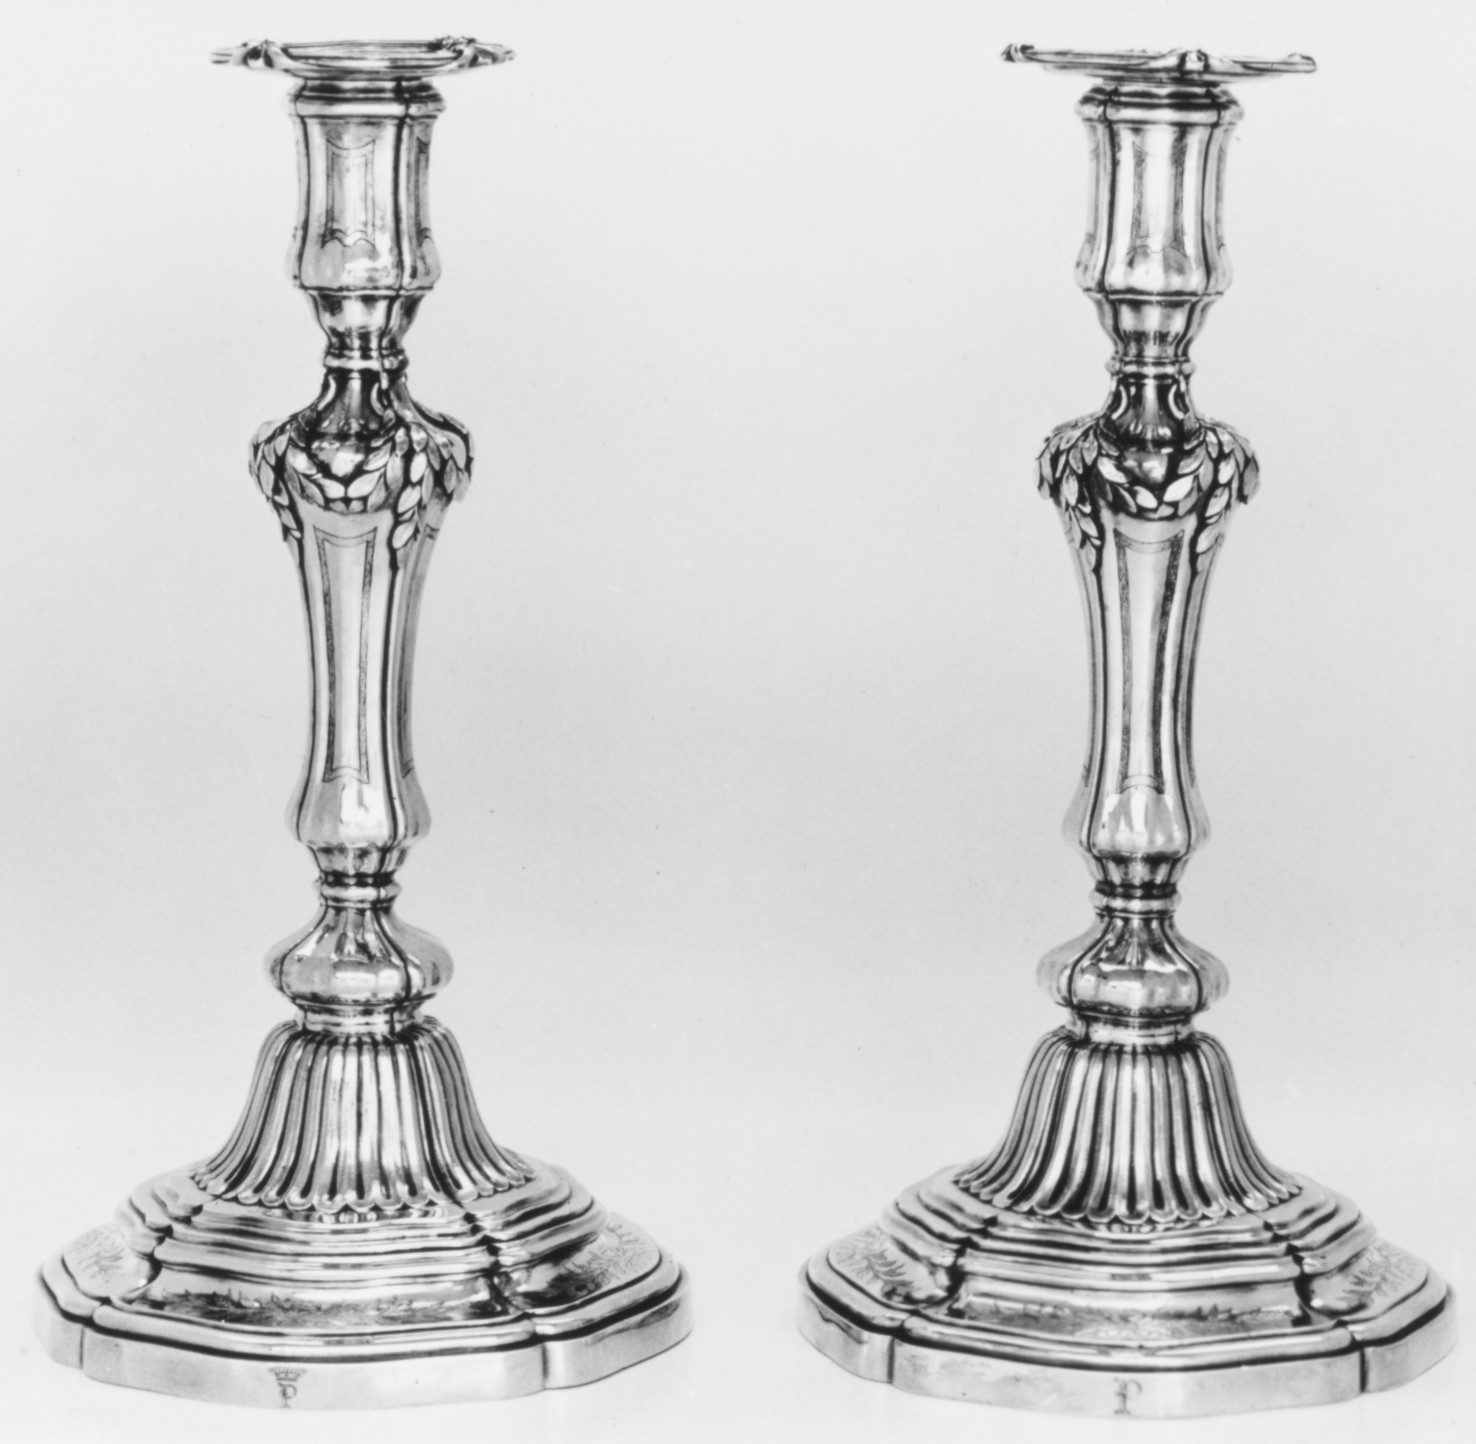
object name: candlestick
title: Pair of candlesticks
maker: jacques roettiers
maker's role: maker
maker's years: 1684-1784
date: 1762-1764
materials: silver